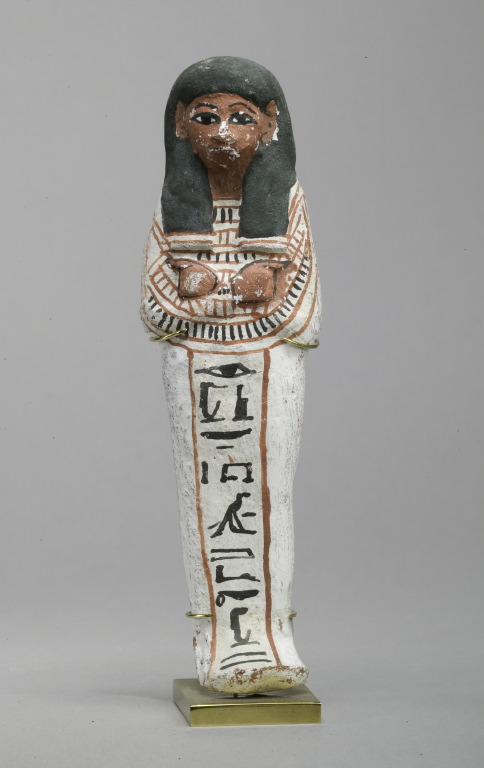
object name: shabti, tamakit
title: Shabti of Tamaket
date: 1279-1213 BCE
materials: paint, pottery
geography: egypt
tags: hieroglyphs